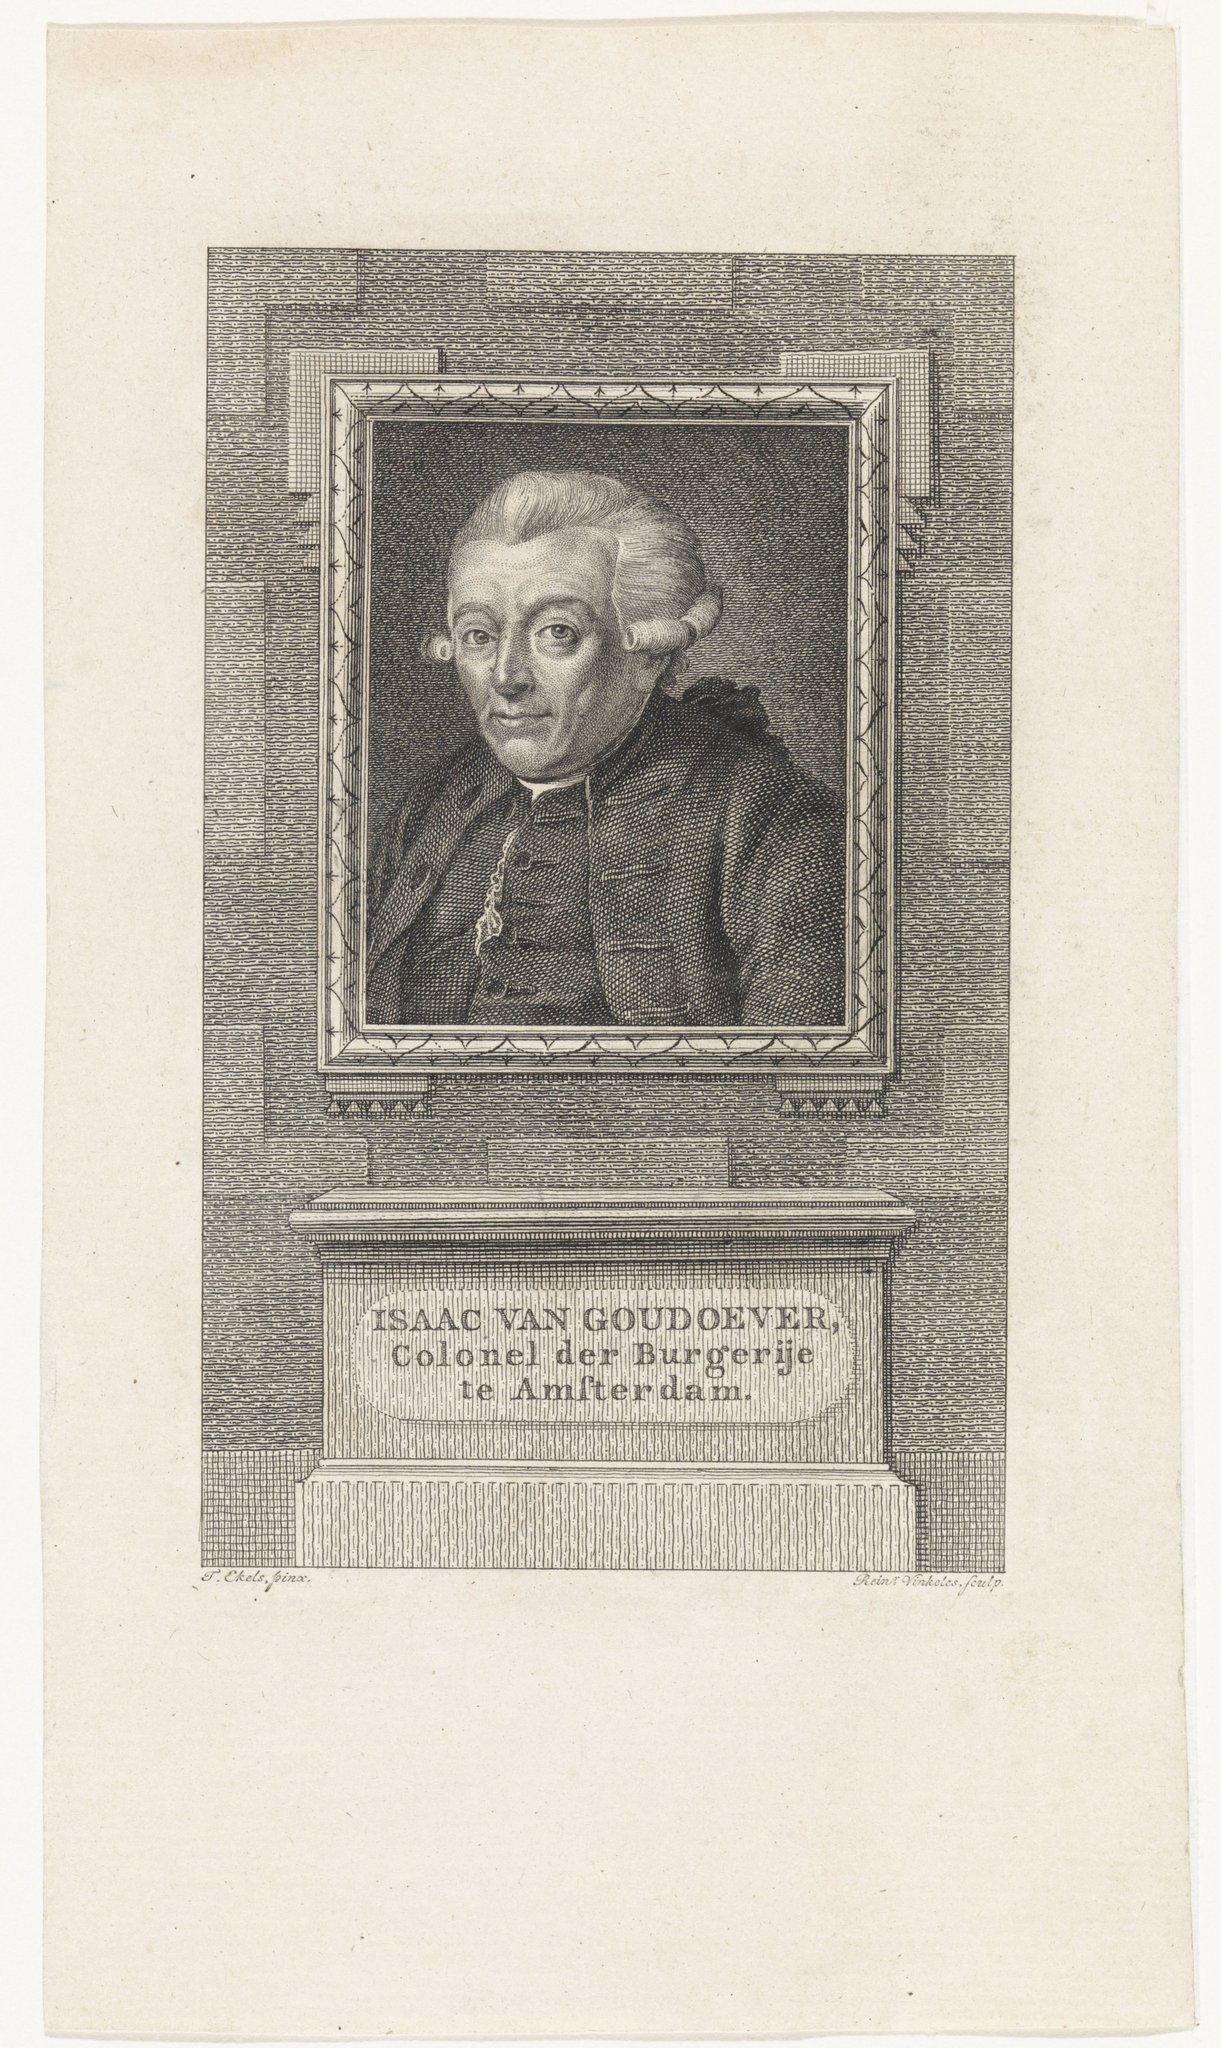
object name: print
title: Portret van Isaak van Goudoever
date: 1786-1809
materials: paper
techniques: engraving, etching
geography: amsterdam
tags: amsterdam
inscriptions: collector's mark: Lugt 2228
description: Prent ook gebruikt als boekillustratie in: Wagenaar, Jan. Vaderlandsche historie, (...) ten vervolge van Wagenaars Vaderlandsche historie. Dl. 1-43. Amsterdam: Johannes Allart, 1786-1809.